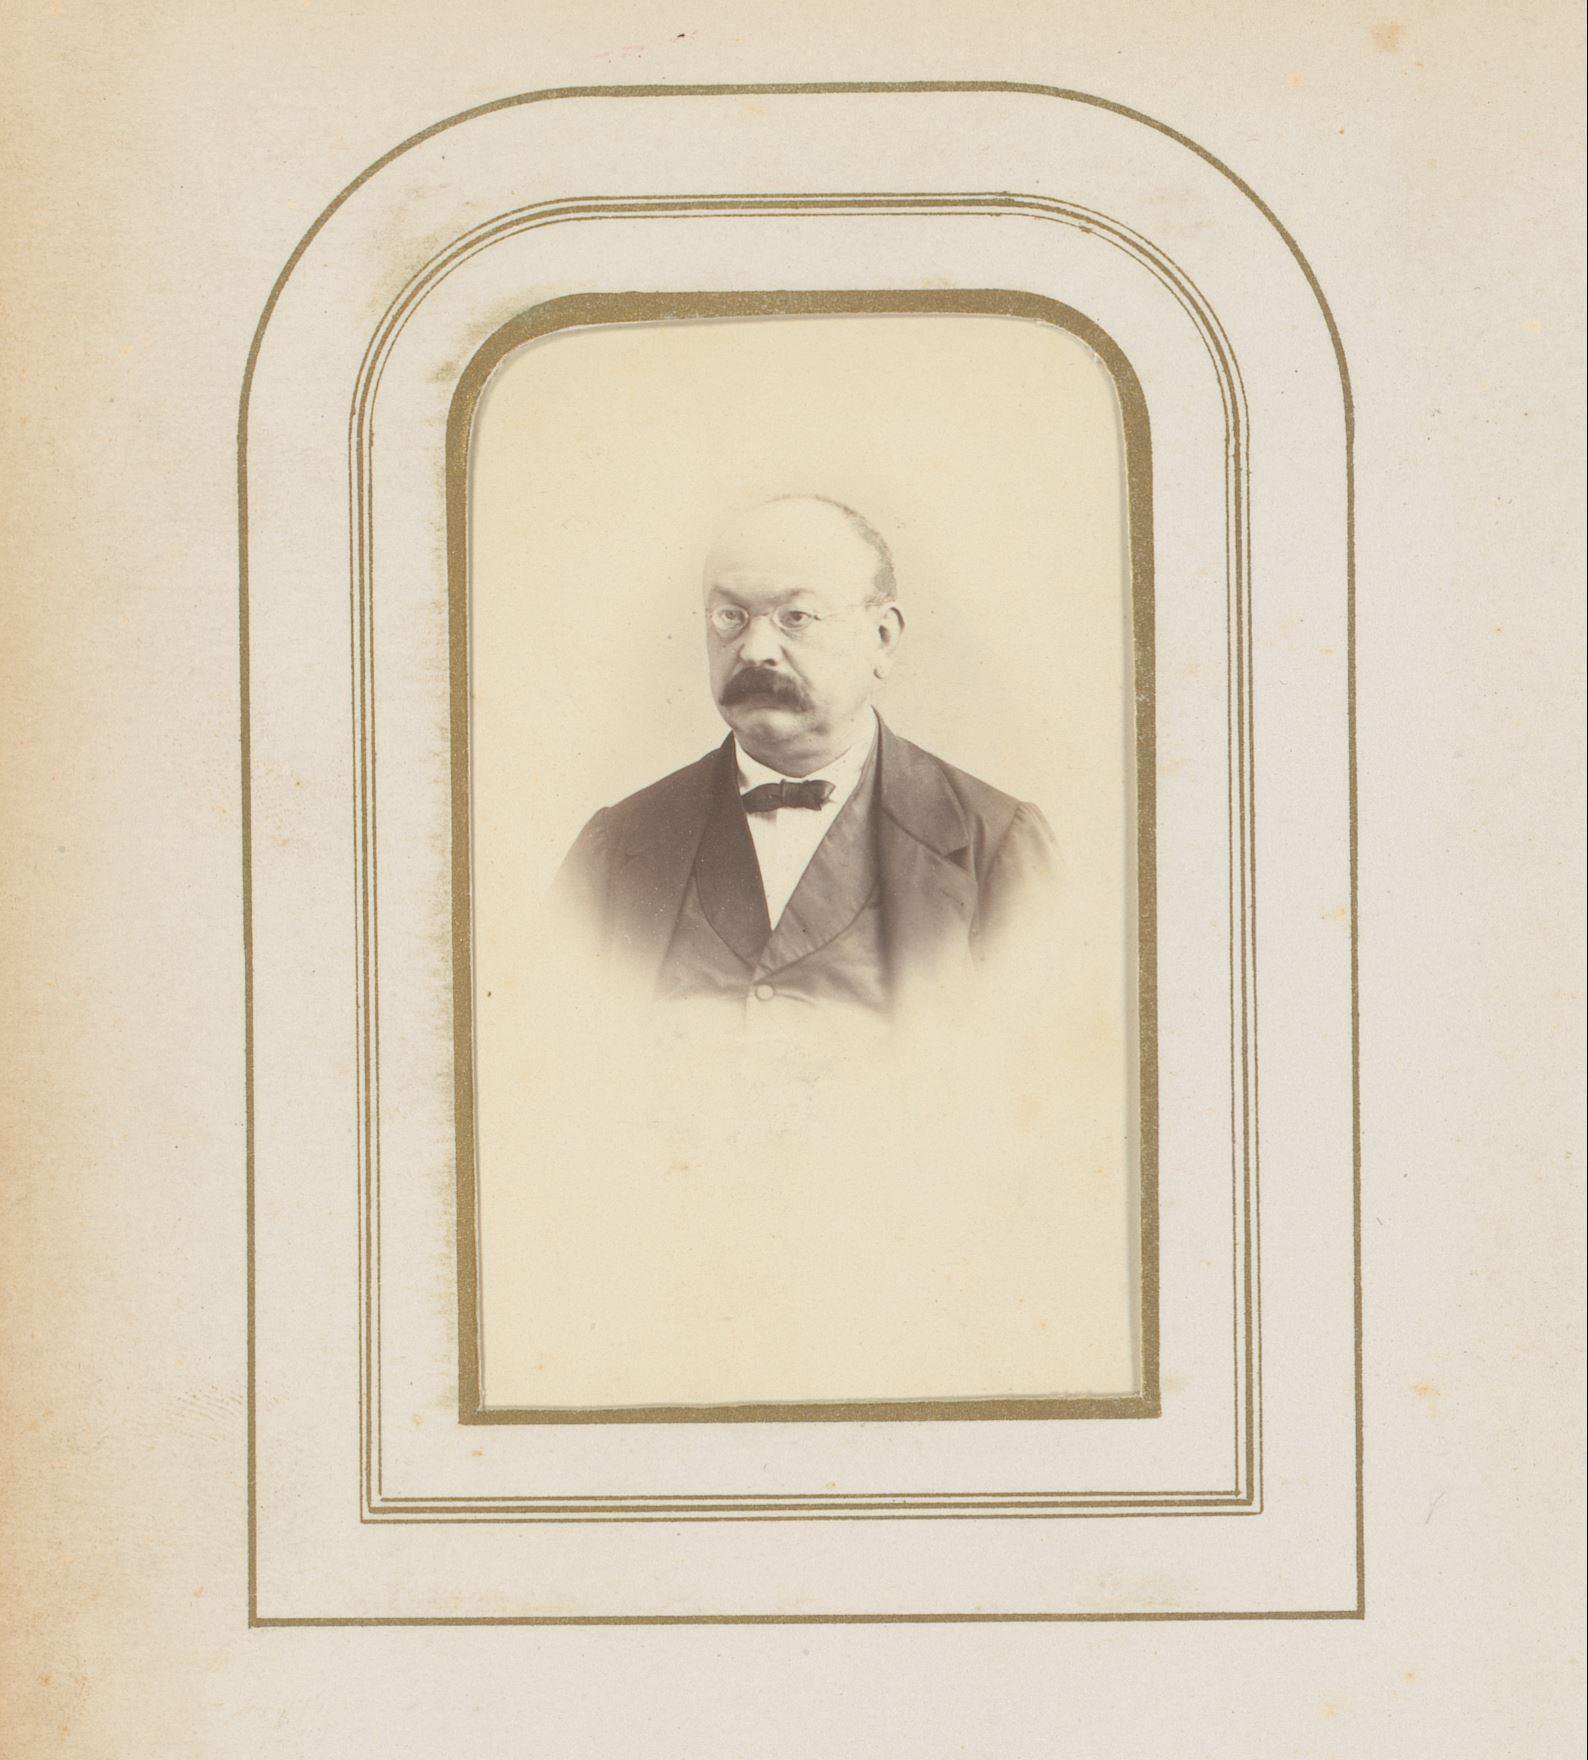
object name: photograph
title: Portret van een man met bril en snor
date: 1866-1890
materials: cardboard, photographic support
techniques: albumen print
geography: luxembourg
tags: eyeglasses, spectacles, moustache, historical persons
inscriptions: inscription: ‘Phoographie/ et atelier de peinture/ Brandebourg & Rissé/ descente de Clausen/ Luxembourg’